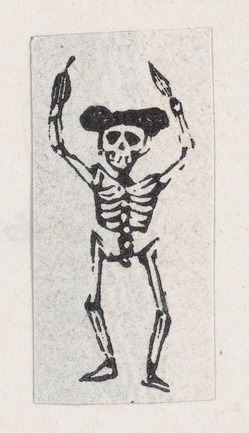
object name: print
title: Skeleton standing with his arms raised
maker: josé guadalupe posada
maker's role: artist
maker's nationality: mexican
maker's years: 1852-1913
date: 1880-1910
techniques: lithography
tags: skeletons